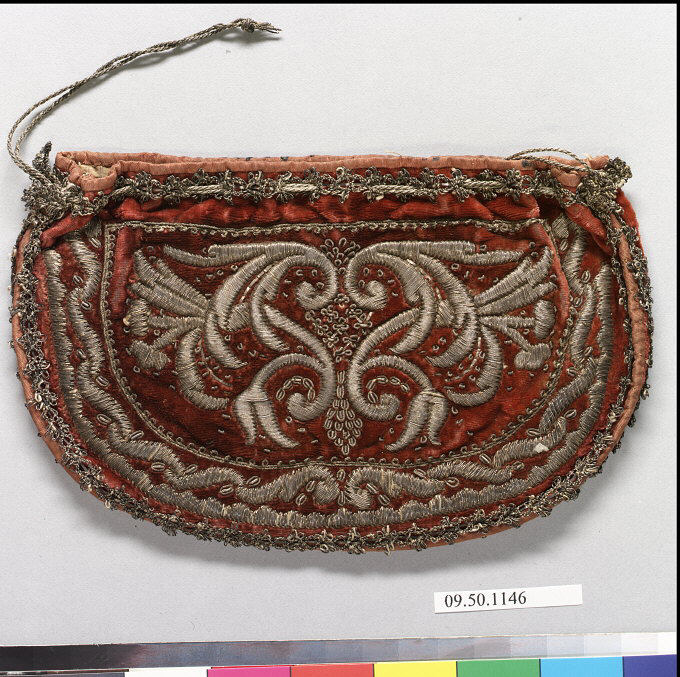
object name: purse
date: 1601-1700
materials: metal thread, velvet